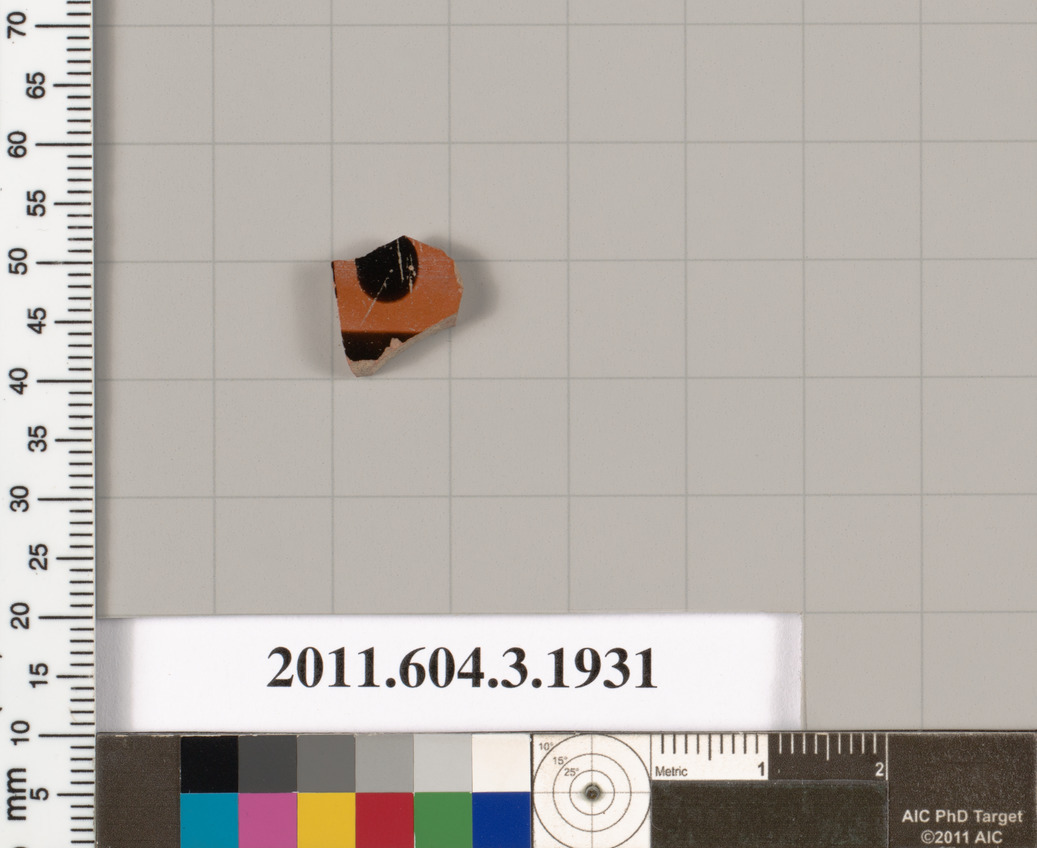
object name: kylix or skyphos fragment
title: Terracotta fragment of a kylix (drinking cup) or a skyphos (deep drinking cup)?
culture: greek, attic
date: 534-468 BCE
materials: terracotta